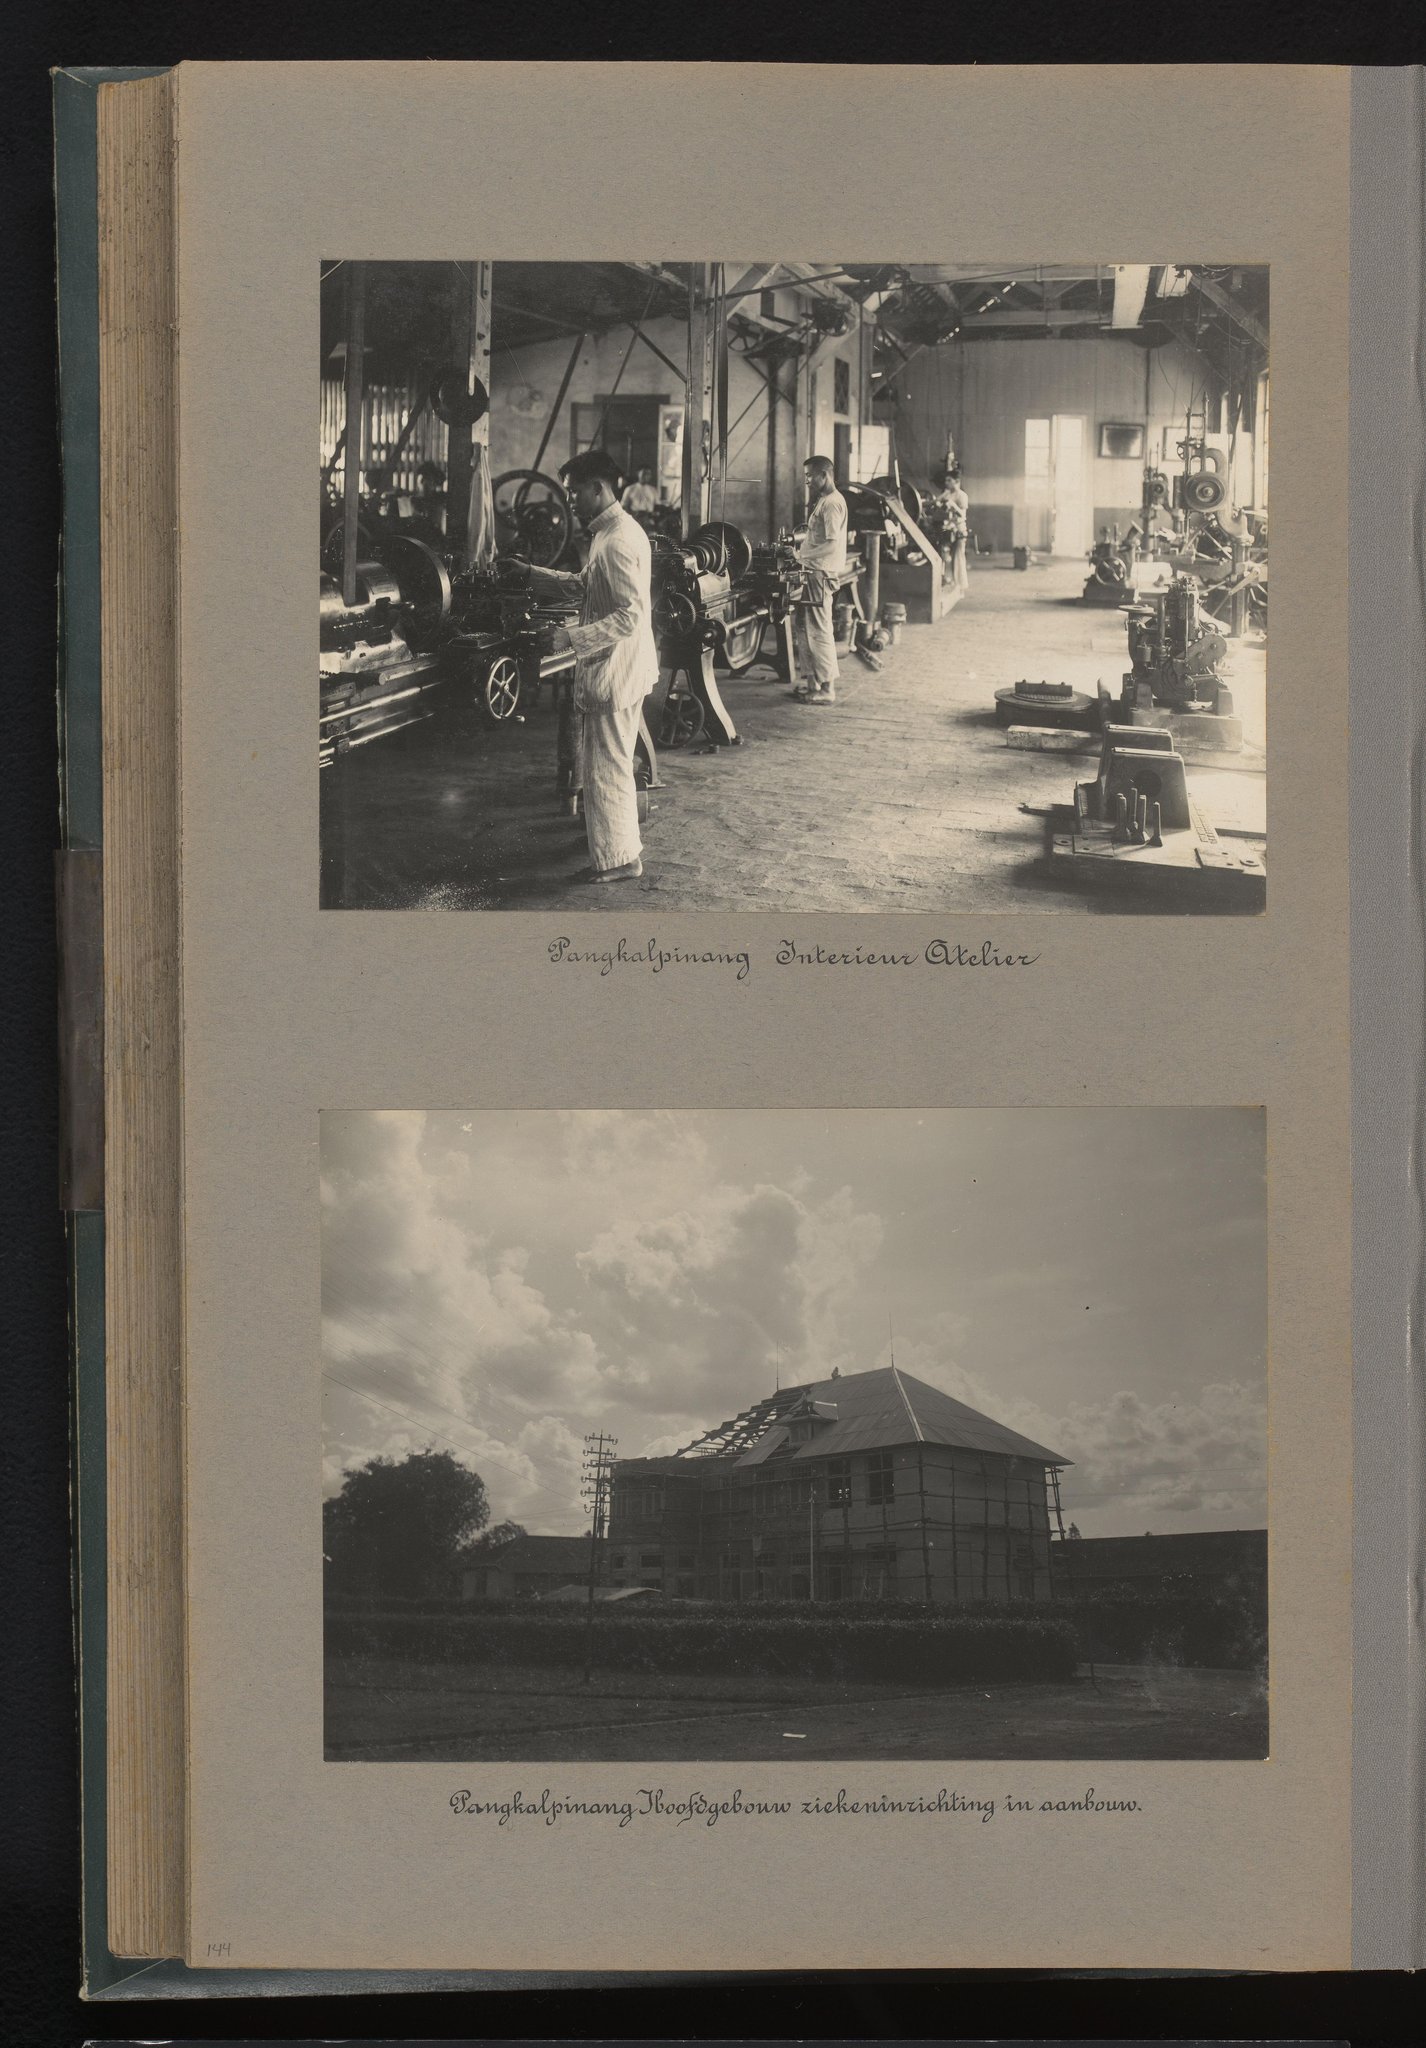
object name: album leaf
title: Atelier en ziekeninrichting te Pangkalpinang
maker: Anonymous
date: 1914-1919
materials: cardboard, photographic support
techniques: gelatin silver print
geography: bangka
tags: robert julius boers, colonial system, mining, factory-interior, machine shop, making the overground structures (~ building activities), hospital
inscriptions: inscription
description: Albumblad met 2 foto's van het interieur van de werkplaats en van het hoofdgebouw van de ziekeninrichting in aanbouw, van de mijnbouwonderneming te Pangkalpinang. Onderdeel van het fotoalbum aangeboden aan Robert Julius Boers bij zijn vertrek naar Nederland in 1919 door het personeel van de Banka-tinwinning.